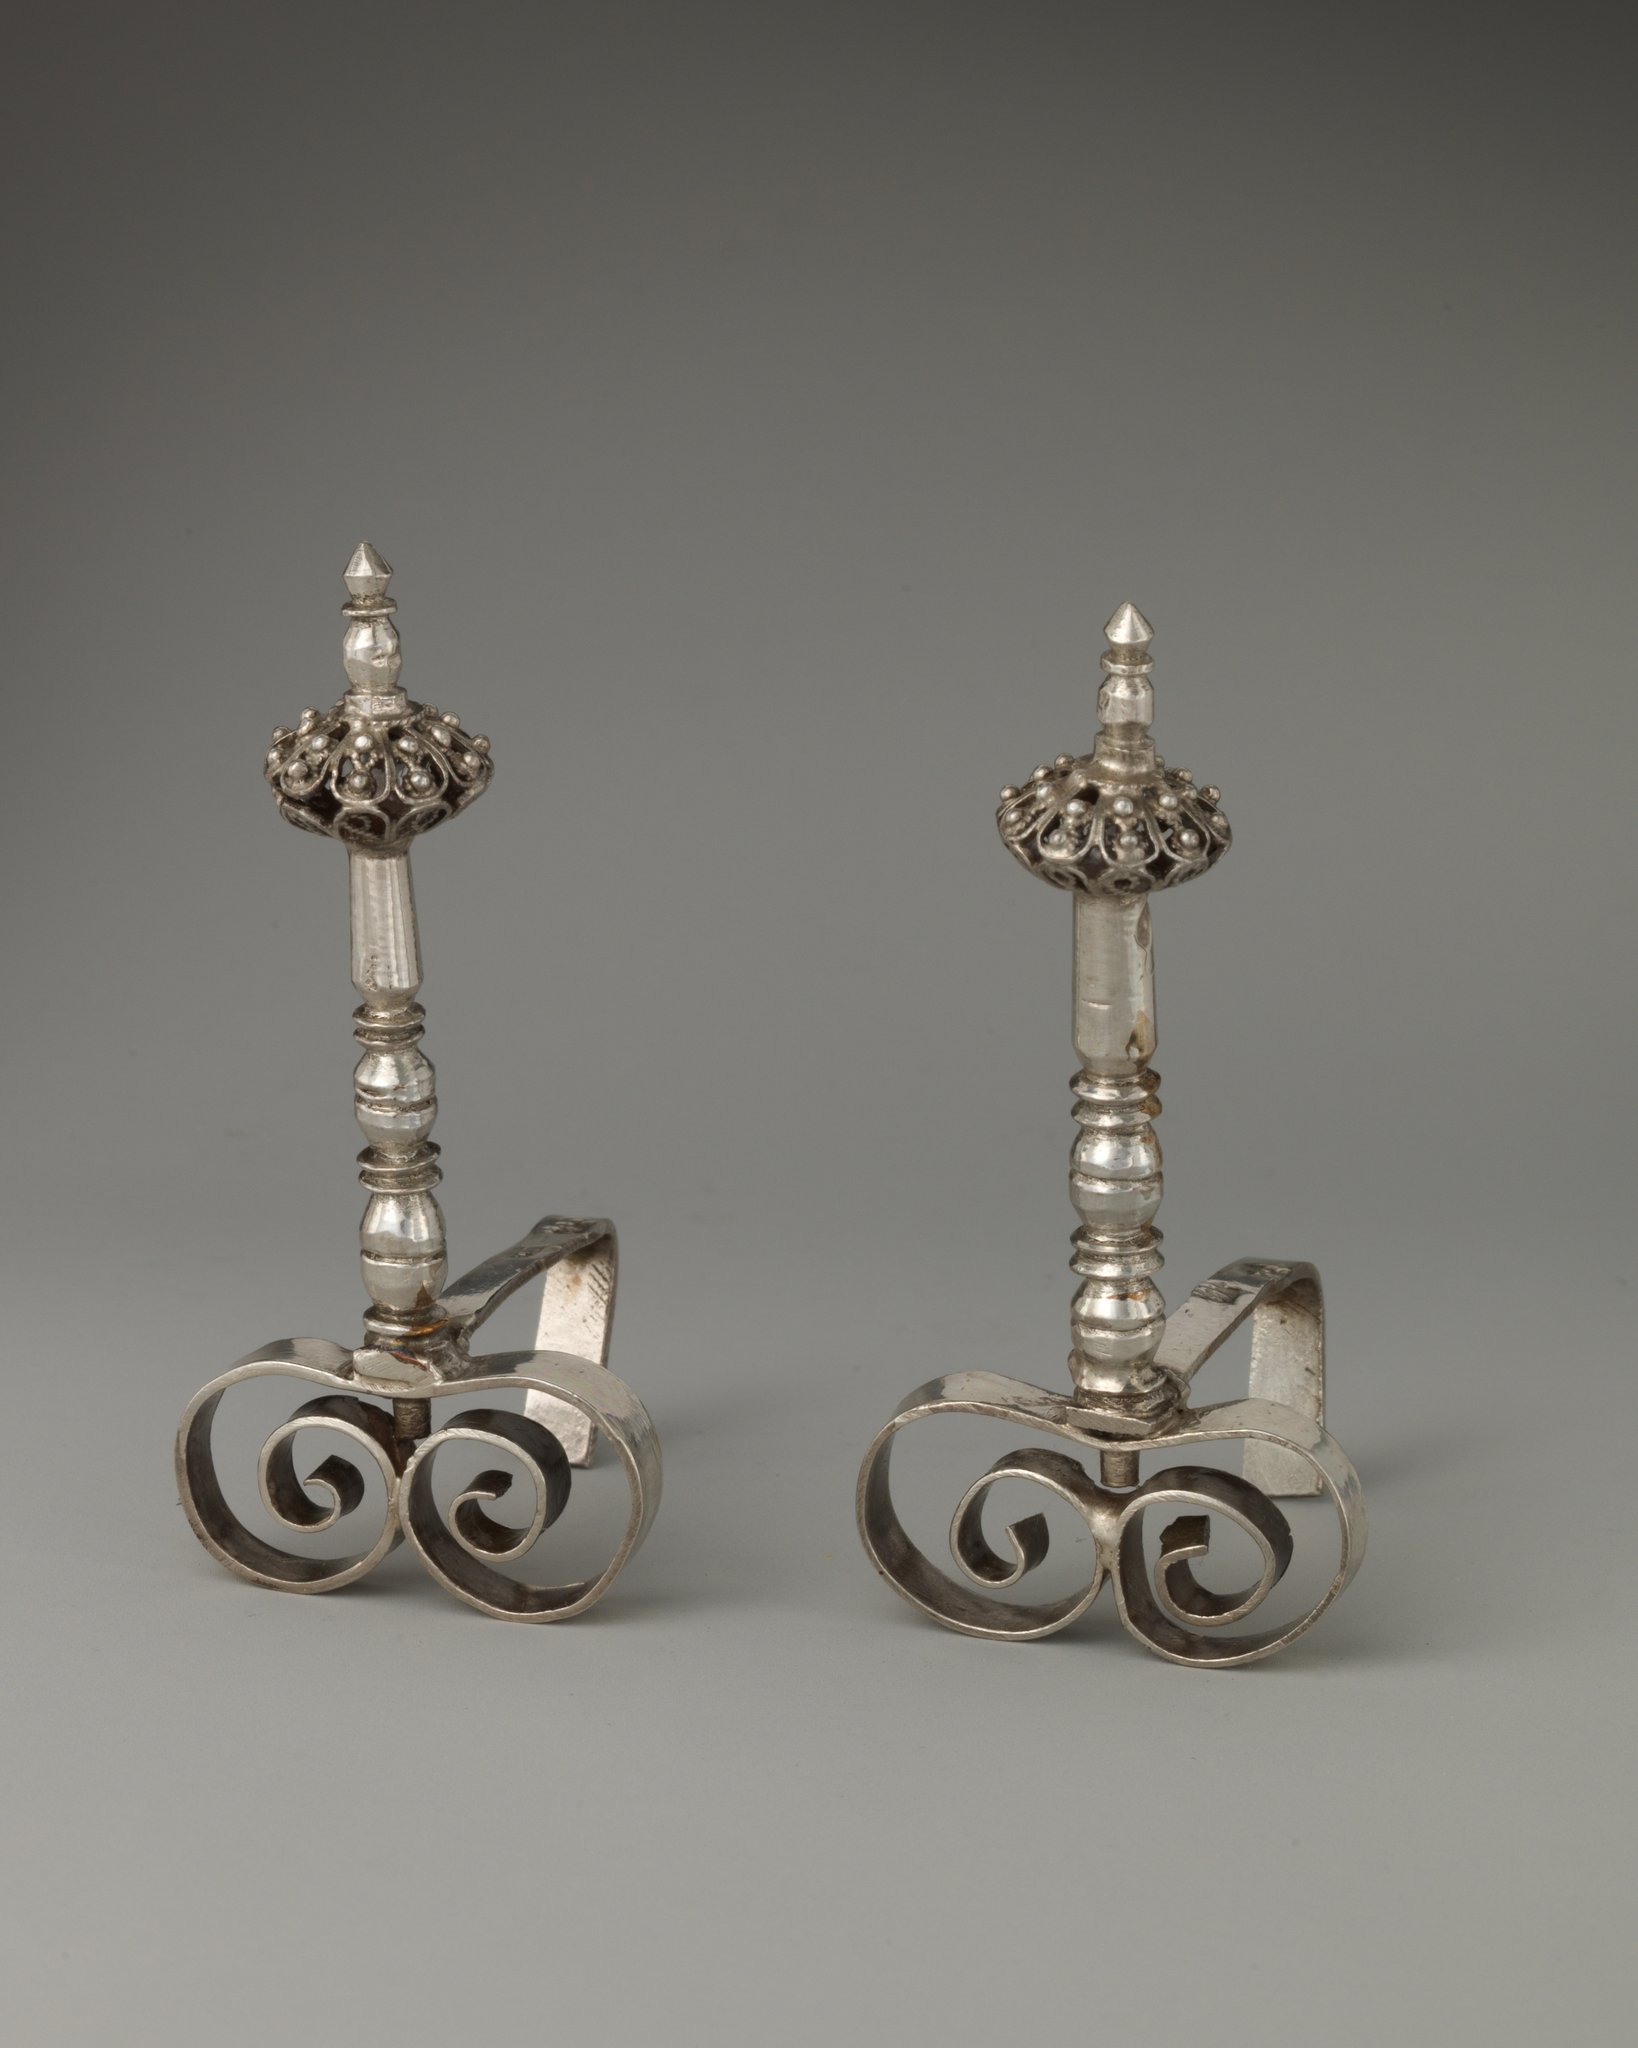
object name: andiron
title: Miniature andiron (one of a pair) (part of a set)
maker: george manjoy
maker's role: artist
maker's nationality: british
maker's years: 1685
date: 1690-1691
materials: silver